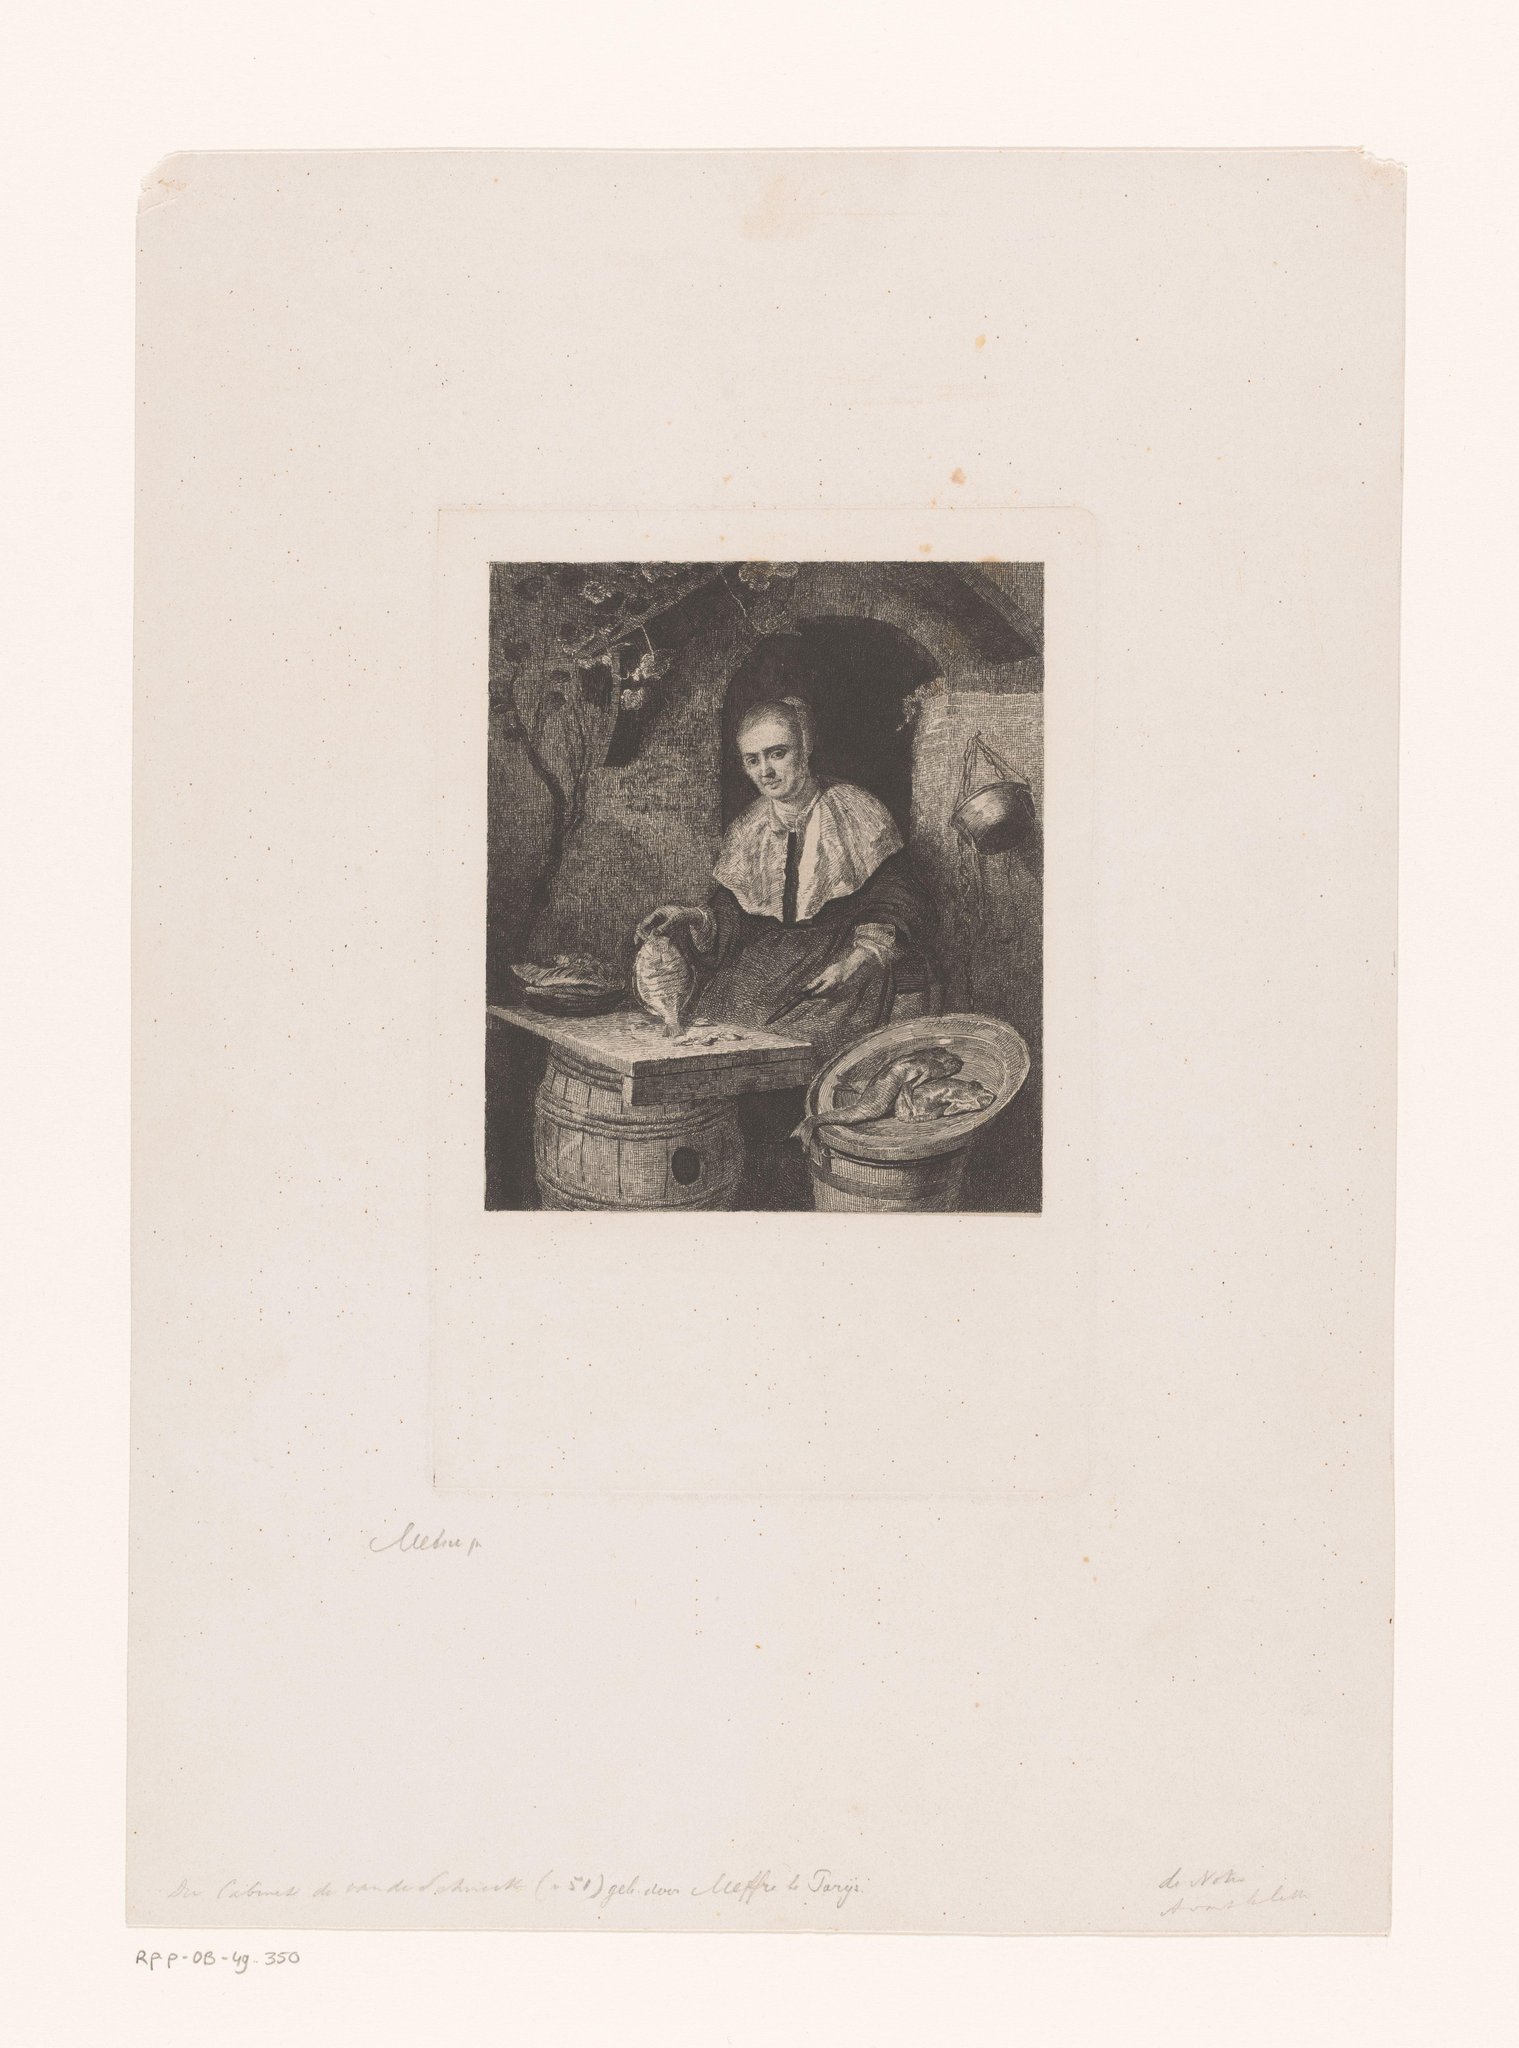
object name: print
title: Vrouw bereidt vis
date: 1840-1875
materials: paper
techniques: etching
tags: wooden container: barrel, cask, bucket, adult woman, fishes, dish, plate, saucer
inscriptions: collector's mark: Lugt 2228